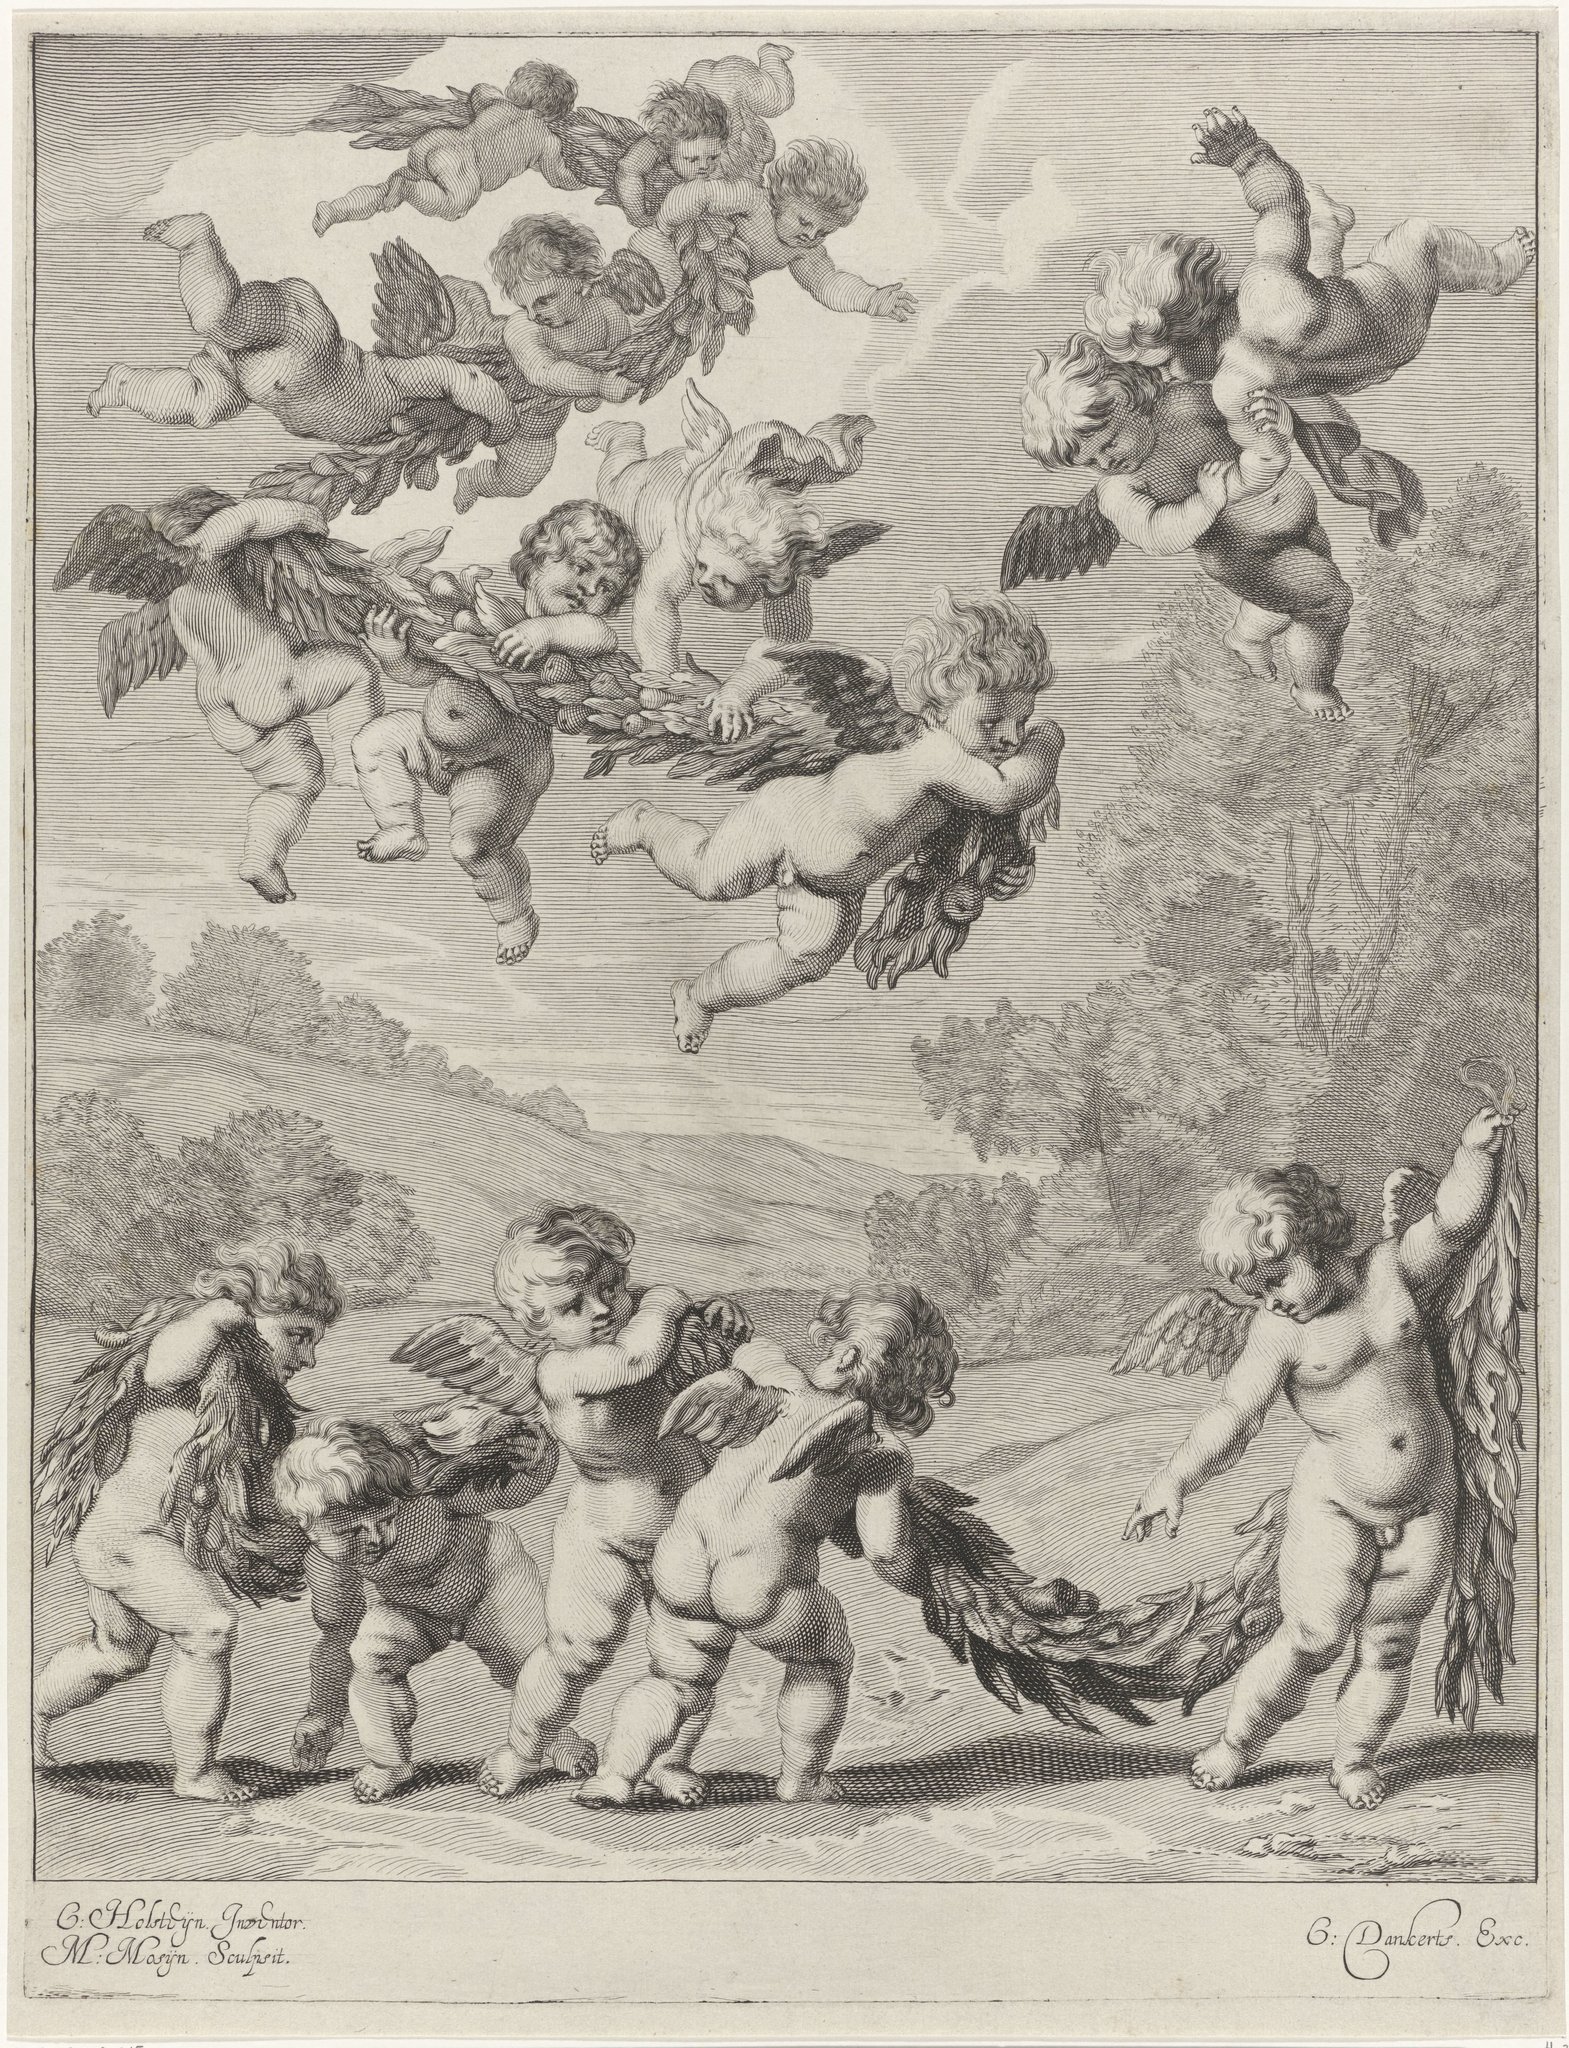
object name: print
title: Aarde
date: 1640-1655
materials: paper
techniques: engraving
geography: amsterdam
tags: earth (one of the four elements), ornament ~ festoon, garland, cupids: 'amores', 'amoretti', 'putti'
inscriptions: collector's mark: Lugt 240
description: In een landschap dragen vijf putti een guirlande van bladeren en vruchten. In de lucht vliegen eveneens putti met een guirlande. Prent uit een serie van de vier elementen.